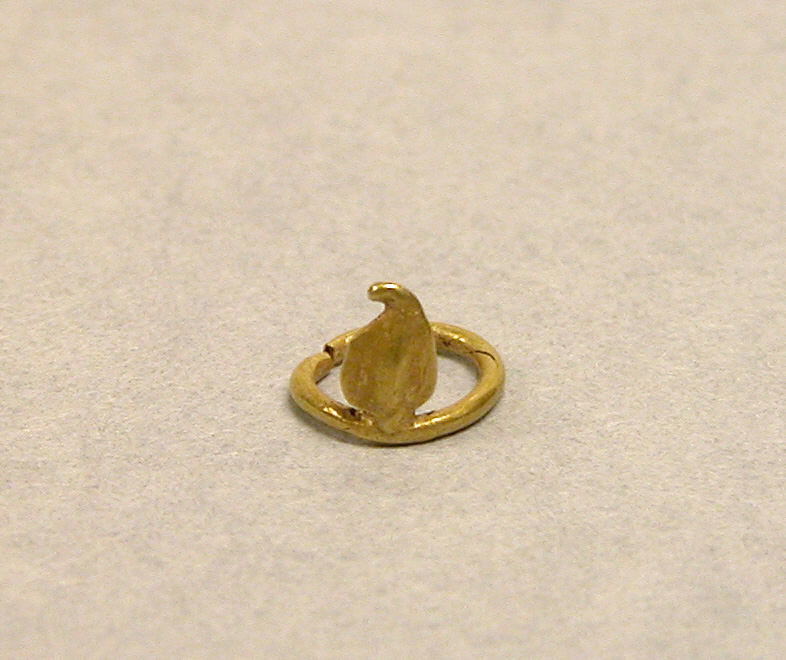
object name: pair of ear ornament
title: Pair of Ear Ornaments, Pendant Leaf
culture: indonesian, central java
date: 701-1200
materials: gold